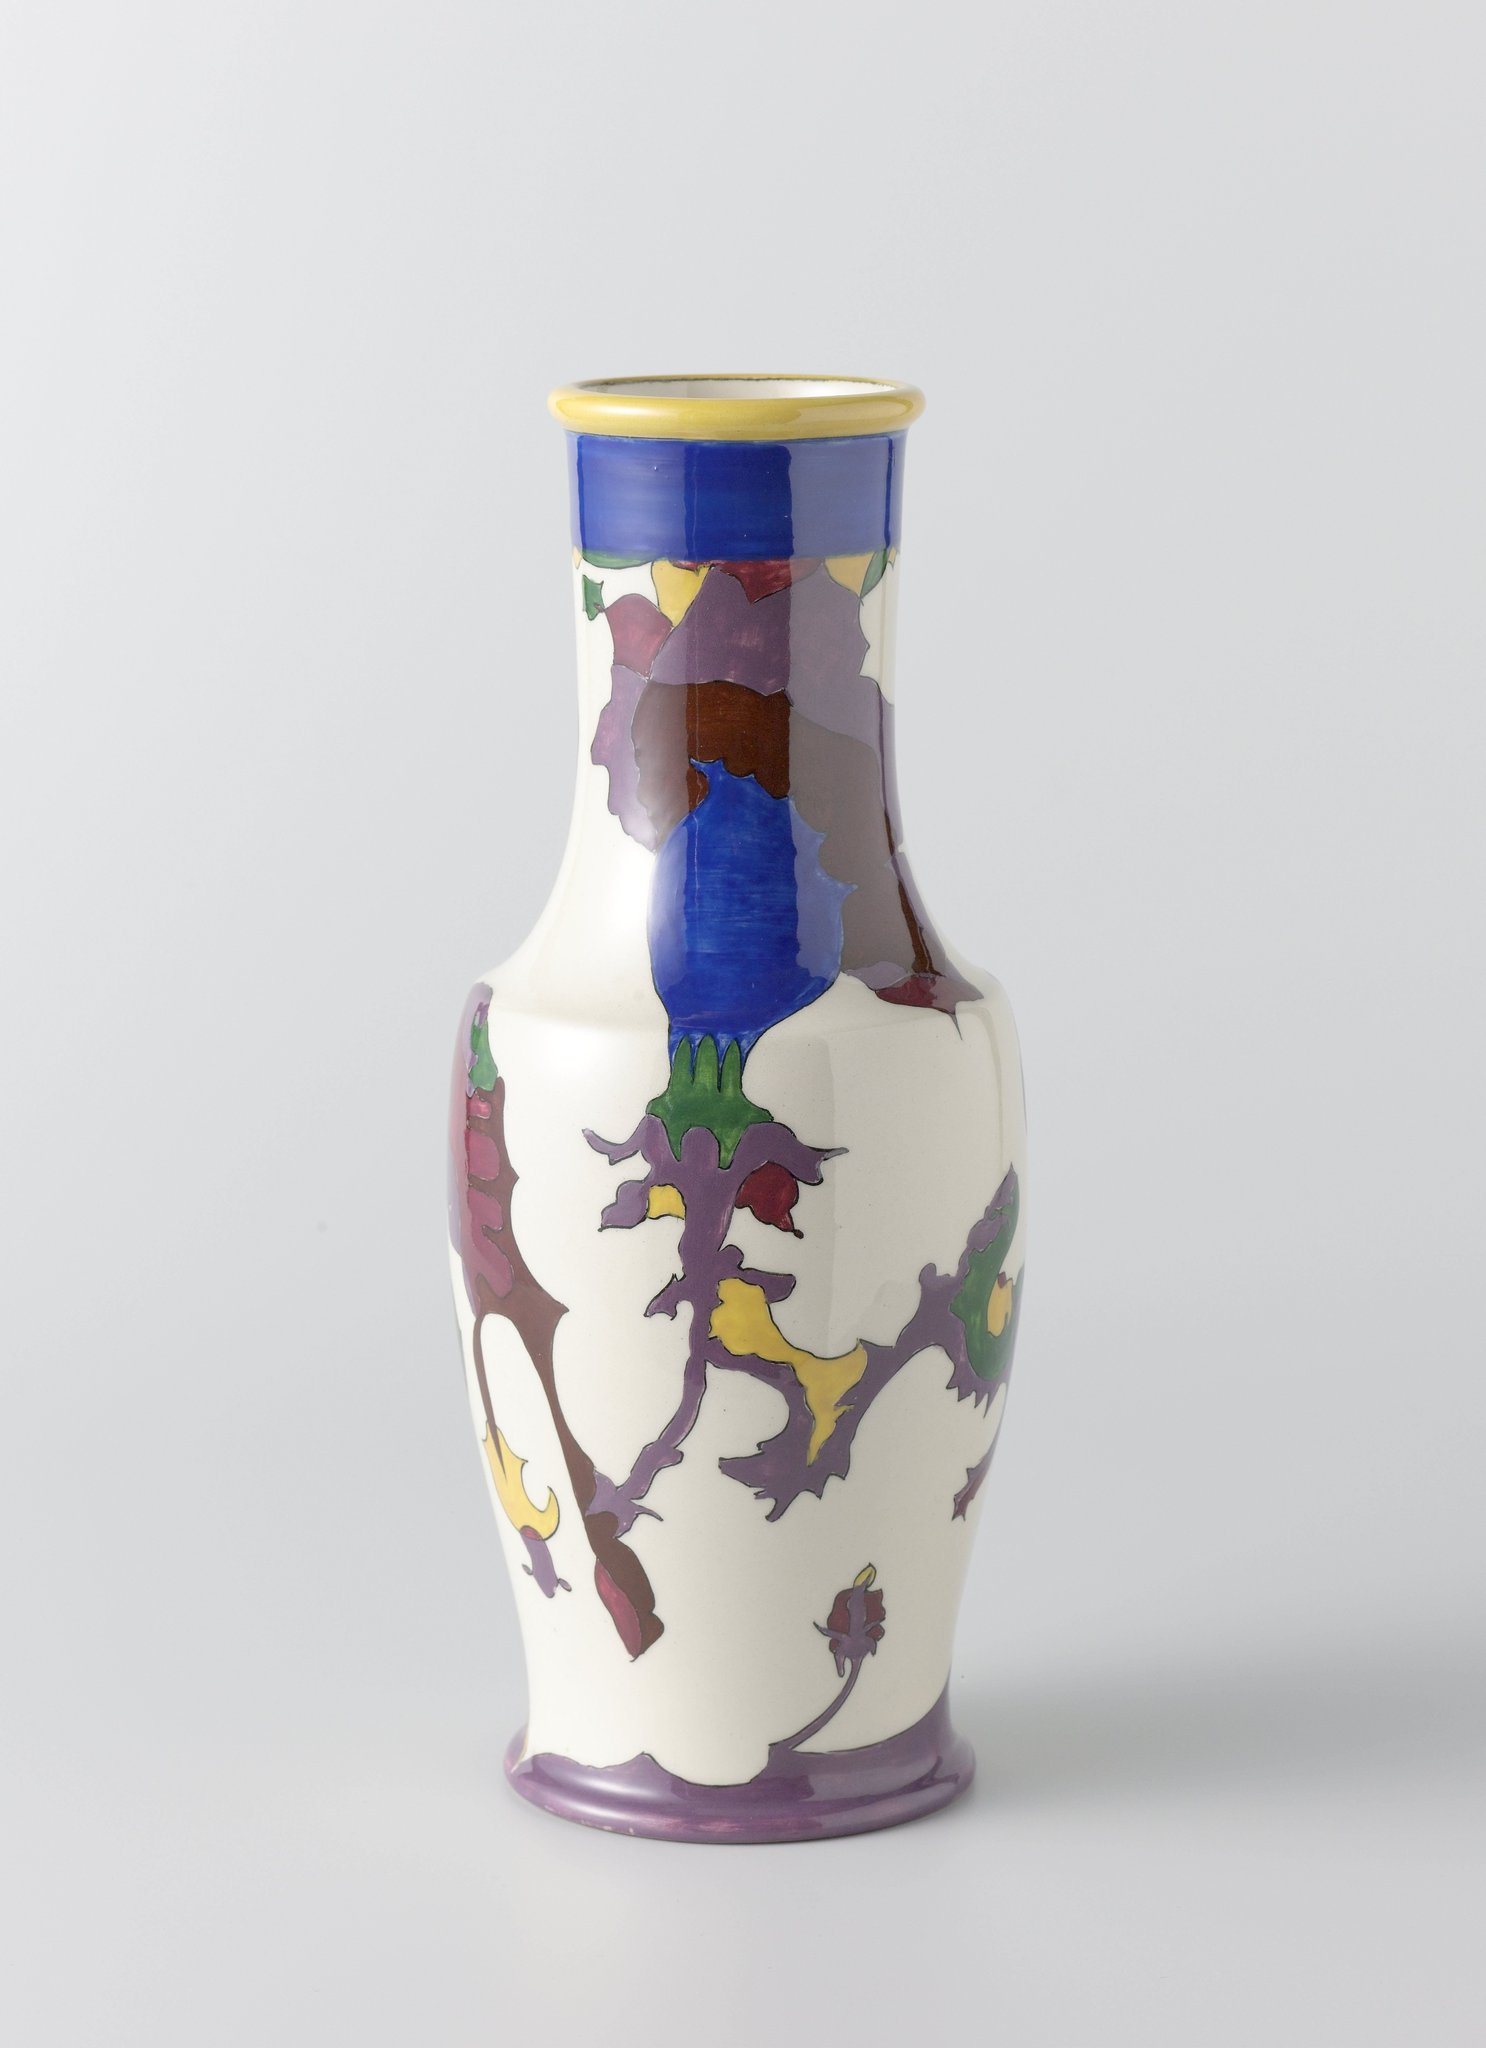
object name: vase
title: Vase with the ‘Tweeling’ (Twin) pattern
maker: theo colenbrander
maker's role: draughtsman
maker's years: 1841-1930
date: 1922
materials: earthenware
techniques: painted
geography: arnhem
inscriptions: mark: ‘Ram, Arnhem, schildersmerk, Dec. Tweeling, 14 (in zwart); en in gegrift: 14.’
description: Vaas van aardewerk, polychroom beschilderd met het decor 'tweeling'. Gemerkt met : Ram, Arnhem, schildersmerk, Dec. Tweeling, 14 (in zwart); en in gegrift: 14.